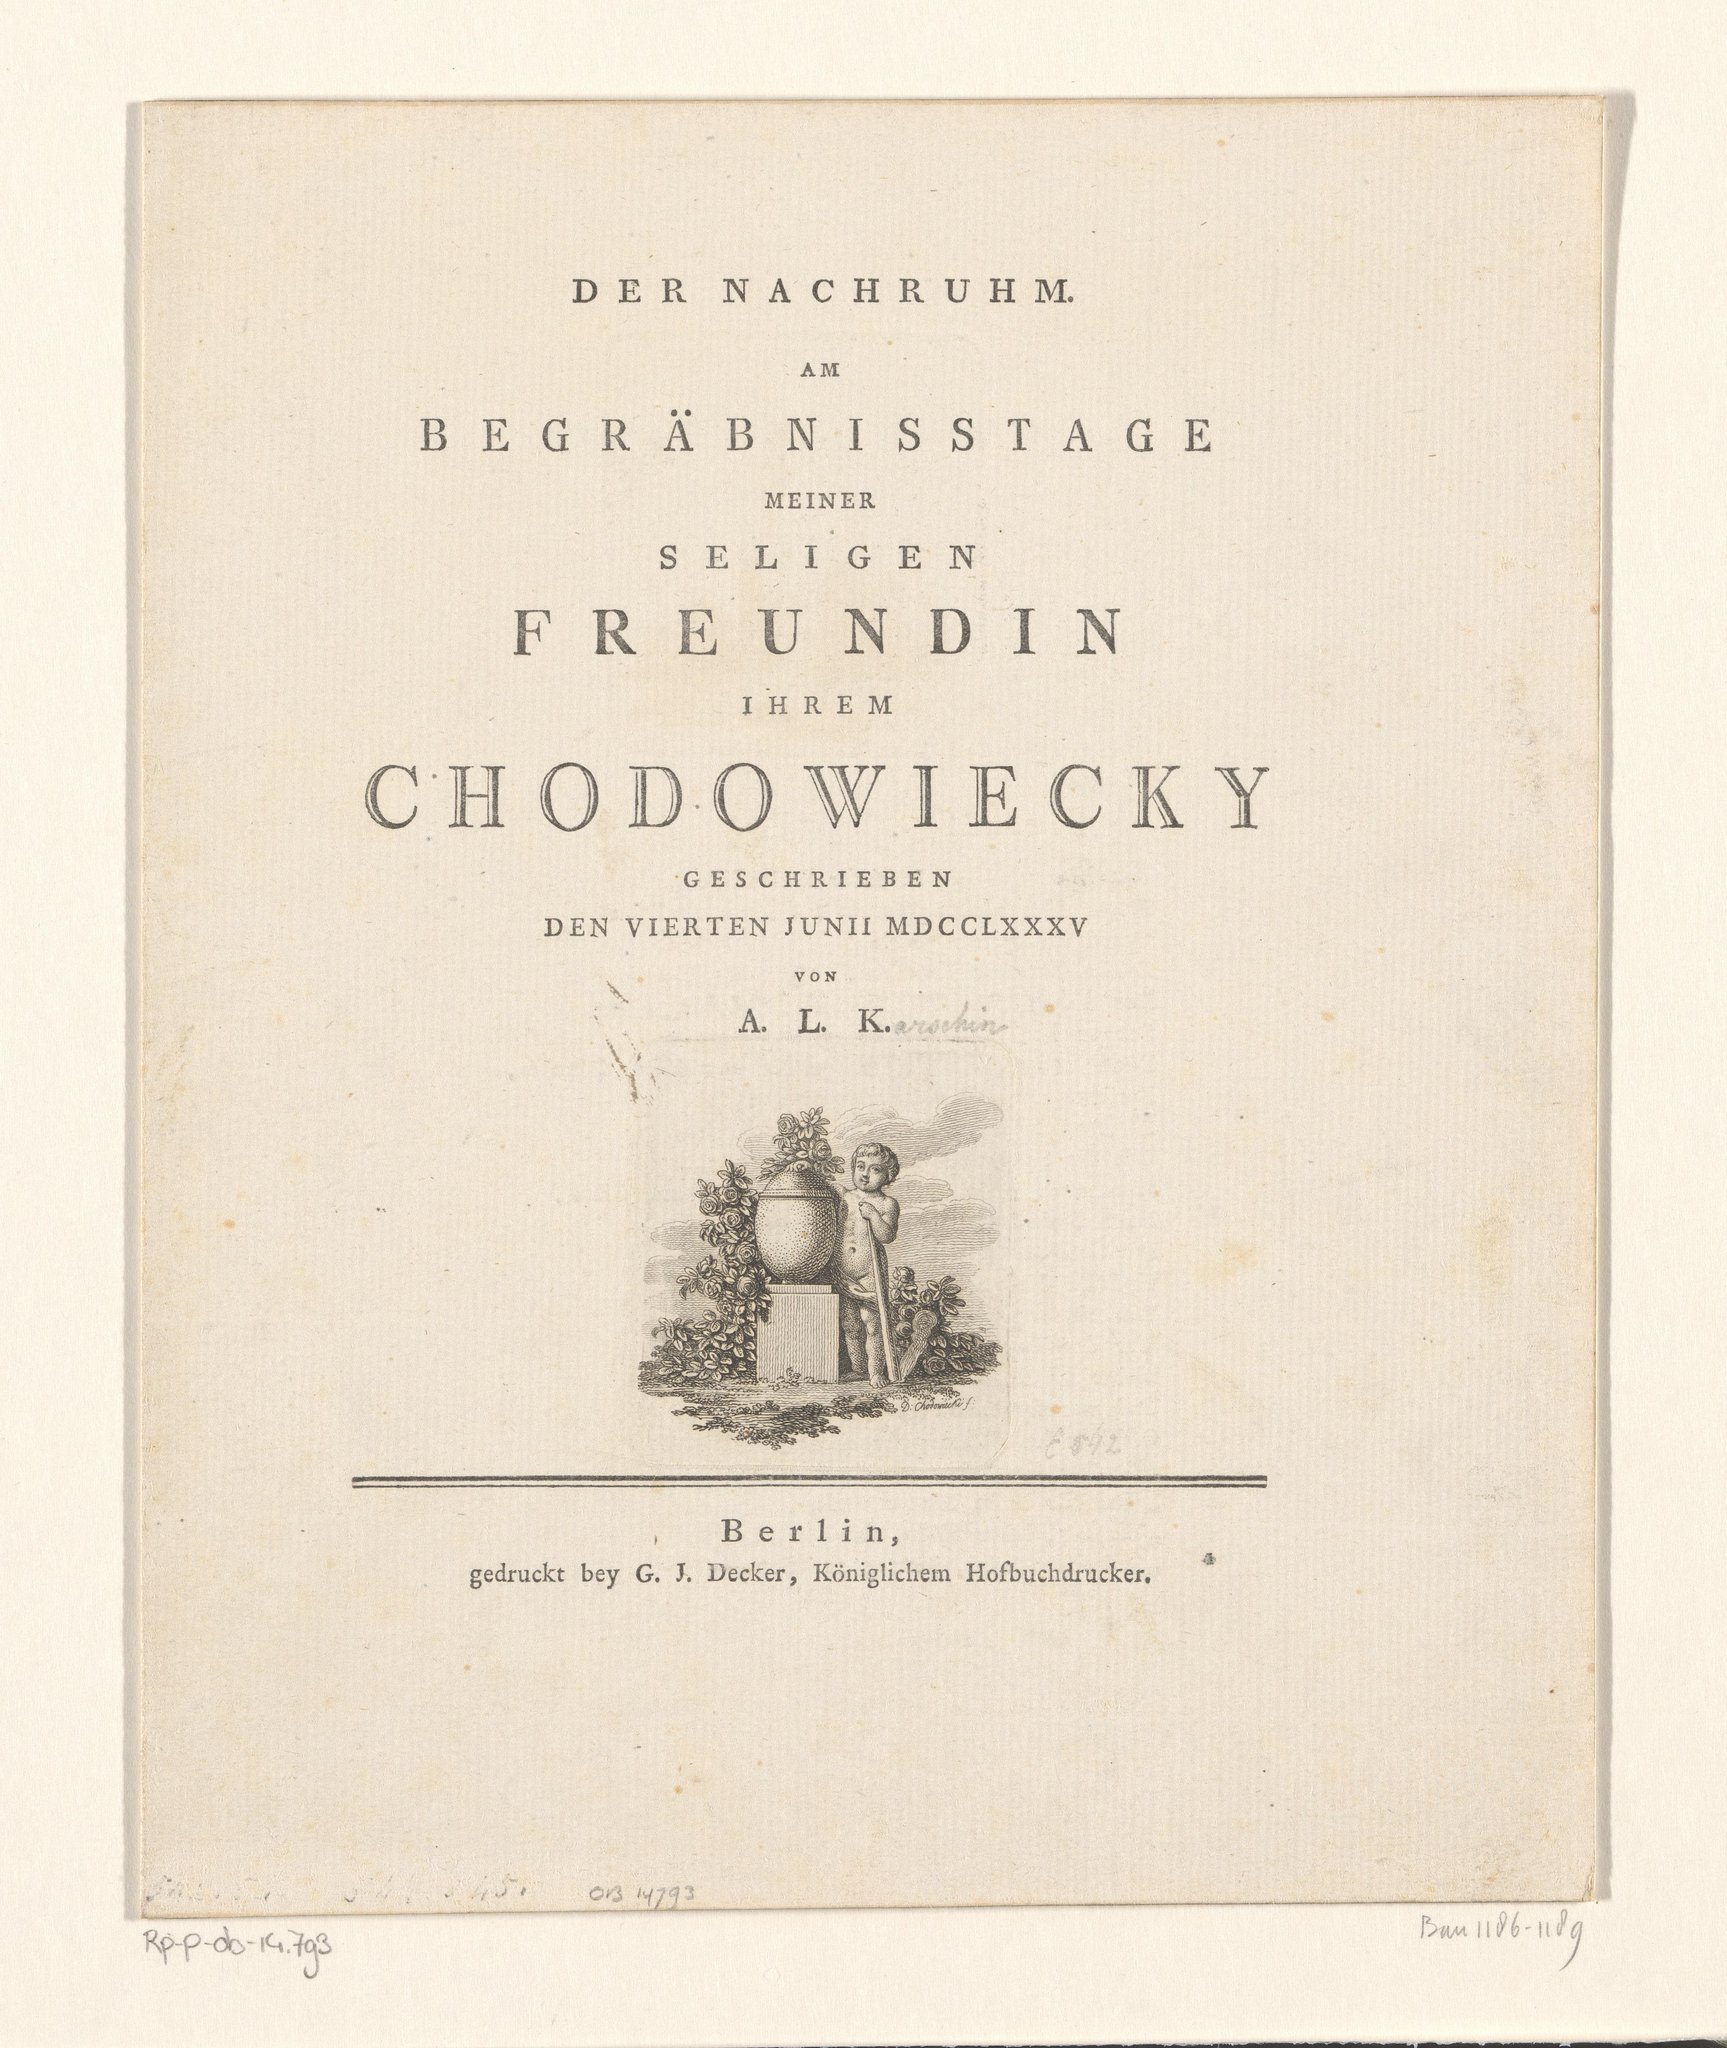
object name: gelegenheidsdrukwerk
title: Vijf allegorische voorstellingen van de dood en twee gedichten in boekdruk op acht bladen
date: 1785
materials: paper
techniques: etching, letterpress printing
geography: berlin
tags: torch - bb - torch held upside down, symbols and personifications of death, garland, wreath, literature, trees: laurel, urn, the all-seeing eye, triangle with eye ~ symbol of god the father, apotheosis (or ascension) of individuals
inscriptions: collector's mark: Lugt 2228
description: Prenten in: Karschin, Anna Luise. Der Nachruhm am Begräbnisstage meiner seligen Freundin ihrem Chodowiecky. Berlijn: G. J. Decker, 1785. Uitgegeven naar aanleiding van het overlijden van de vrouw van Daniel Nikolaus Chodowiecki.